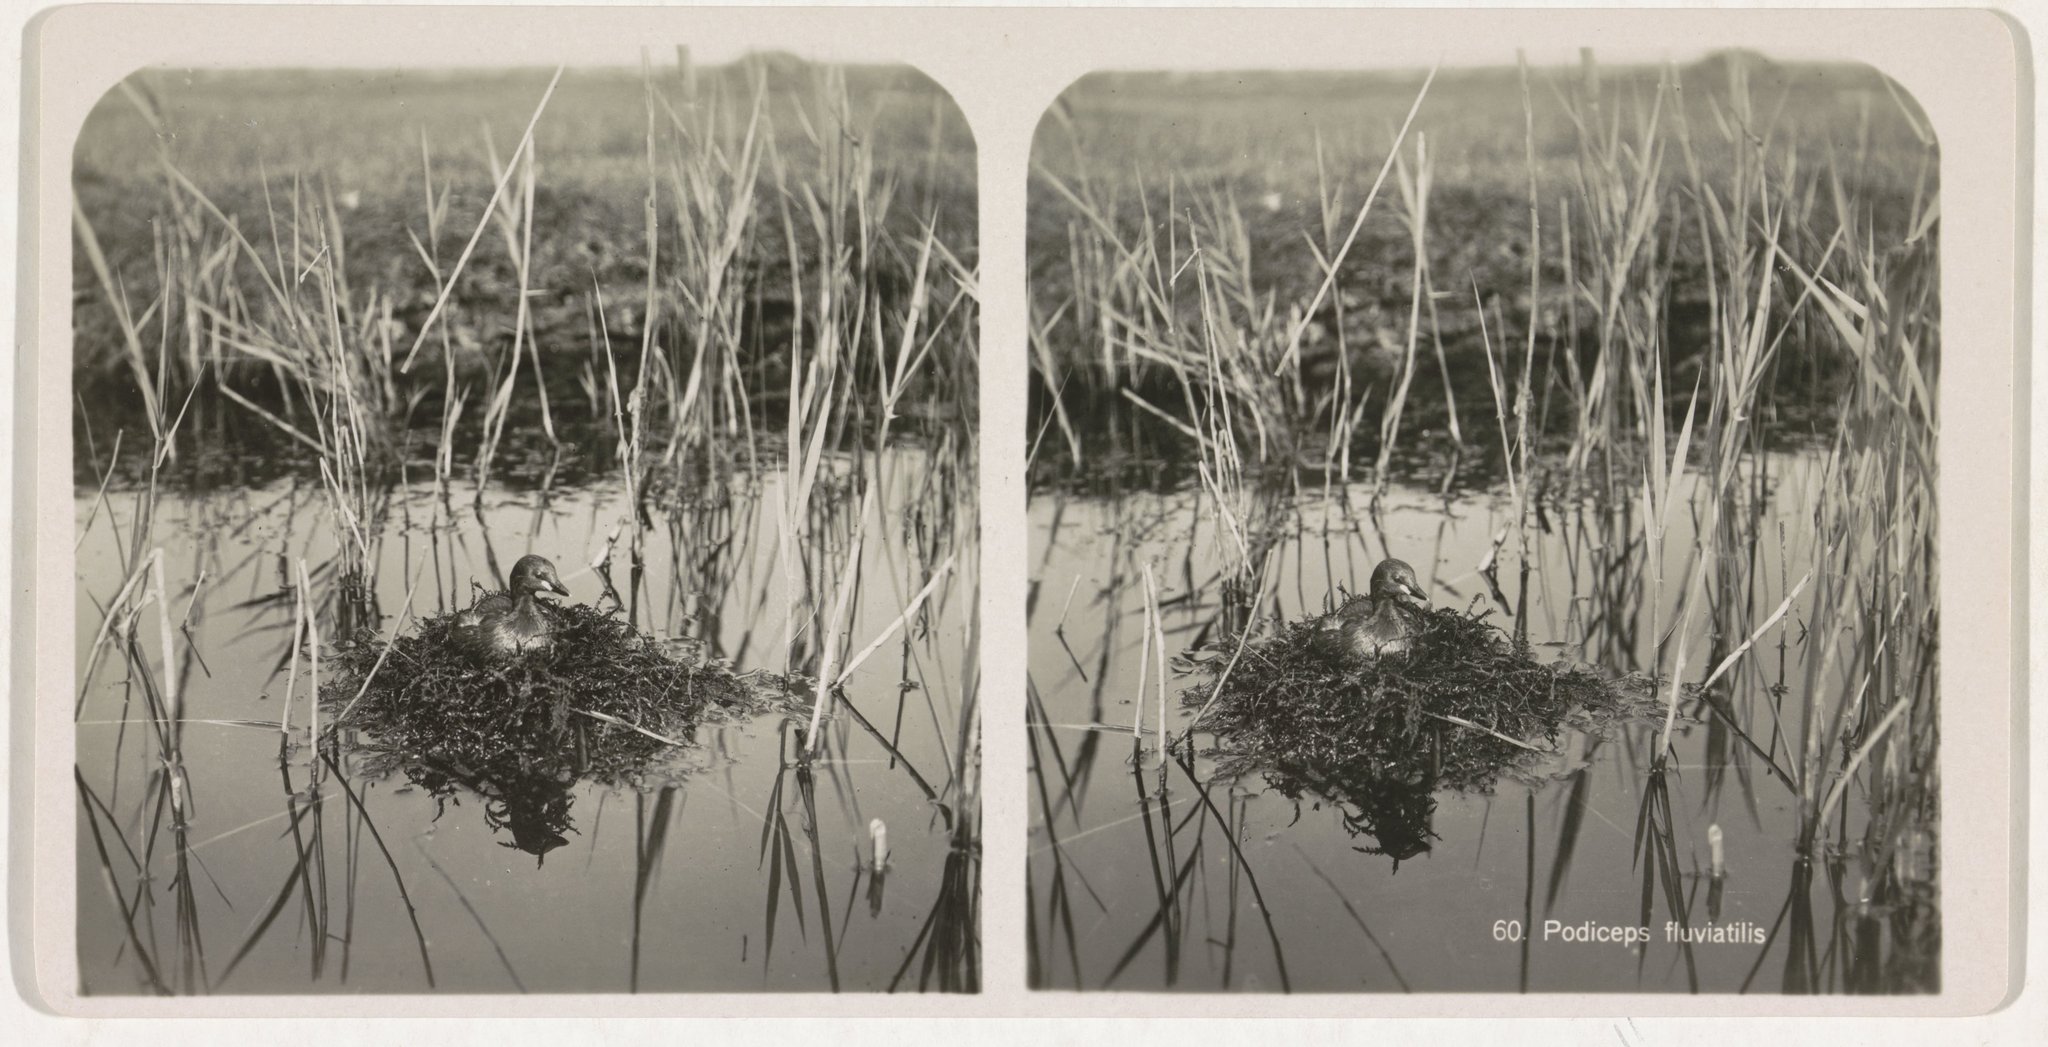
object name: photograph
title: 60. Podiceps fluviatilis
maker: adolphe burdet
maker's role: fotograaf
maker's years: 1860-1940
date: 1870-1940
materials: photographic support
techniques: gelatin silver print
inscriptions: label: ‘Fuut’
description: De foto is afkomstig uit een serie van 12 stereofoto's met moerasvogels die bewaard worden in het originele mapje. Bij dit mapje zit ook een blaadje met gedrukte tekst over de vogels.